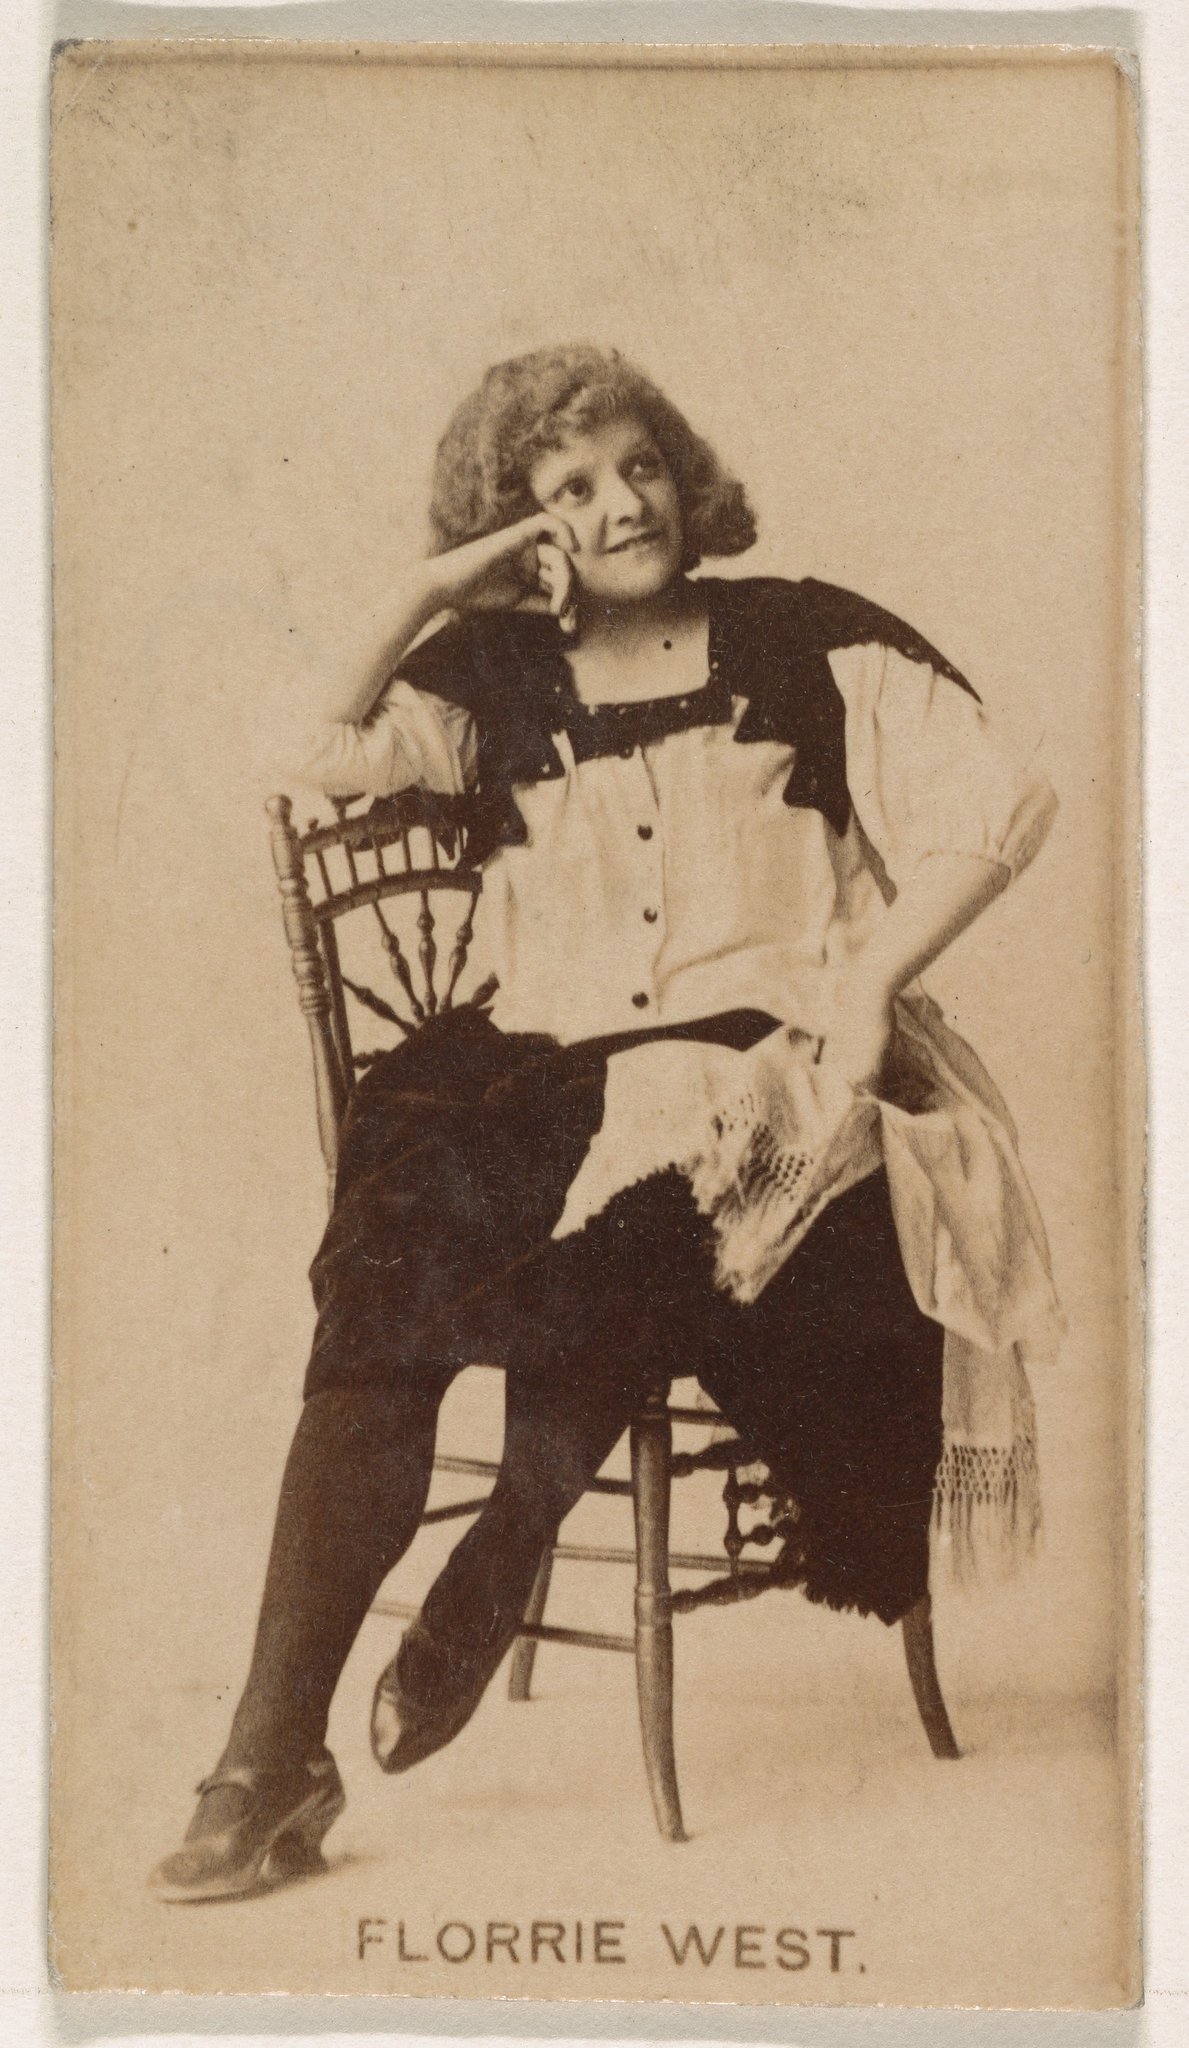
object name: photograph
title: Florrie West, from the Actresses series (N245) issued by Kinney Brothers to promote Sweet Caporal Cigarettes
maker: kinney brothers tobacco company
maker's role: publisher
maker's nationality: american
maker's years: 1869-2011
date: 1890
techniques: albumen silver print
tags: portraits,women,actresses